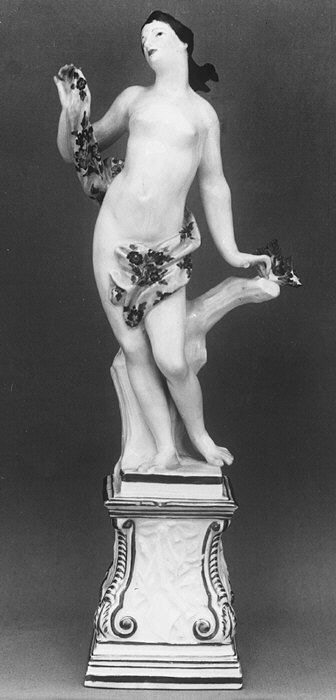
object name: figure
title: Venus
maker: meissen manufactory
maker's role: manufactory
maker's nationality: german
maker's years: 1710-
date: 1744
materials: hard paste porcelain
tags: venus